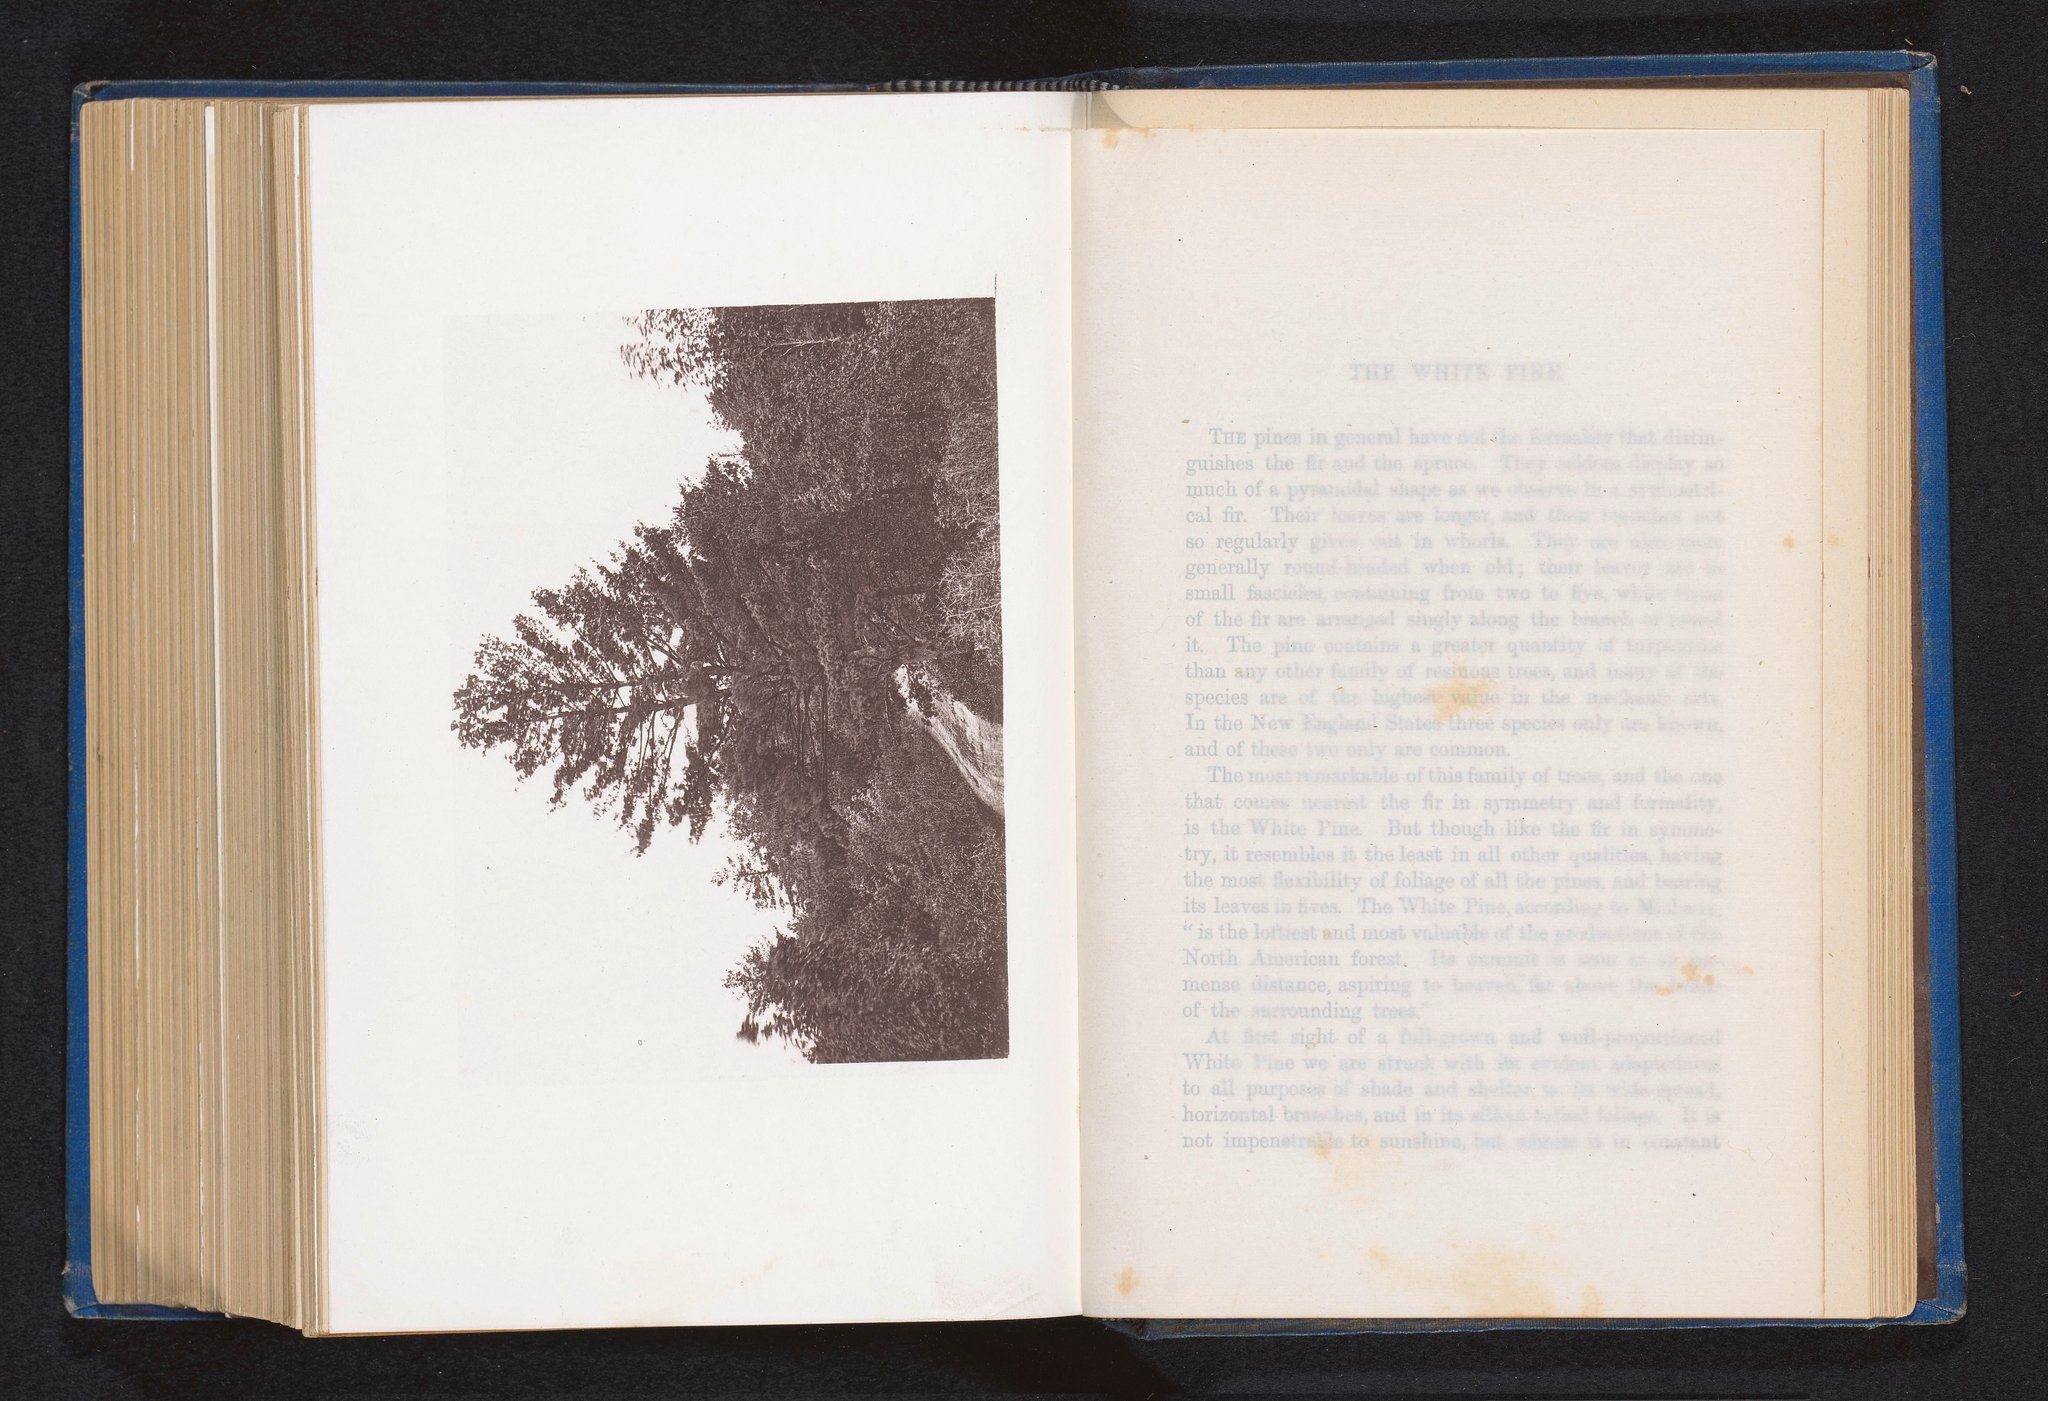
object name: page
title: Gezicht op een weymouthden te Melrose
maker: Anonymous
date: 1872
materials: paper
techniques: photograph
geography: melrose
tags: landscapes, forest, wood, trees: pine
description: Prent op tweede ongenummerde pagina na pagina 410.